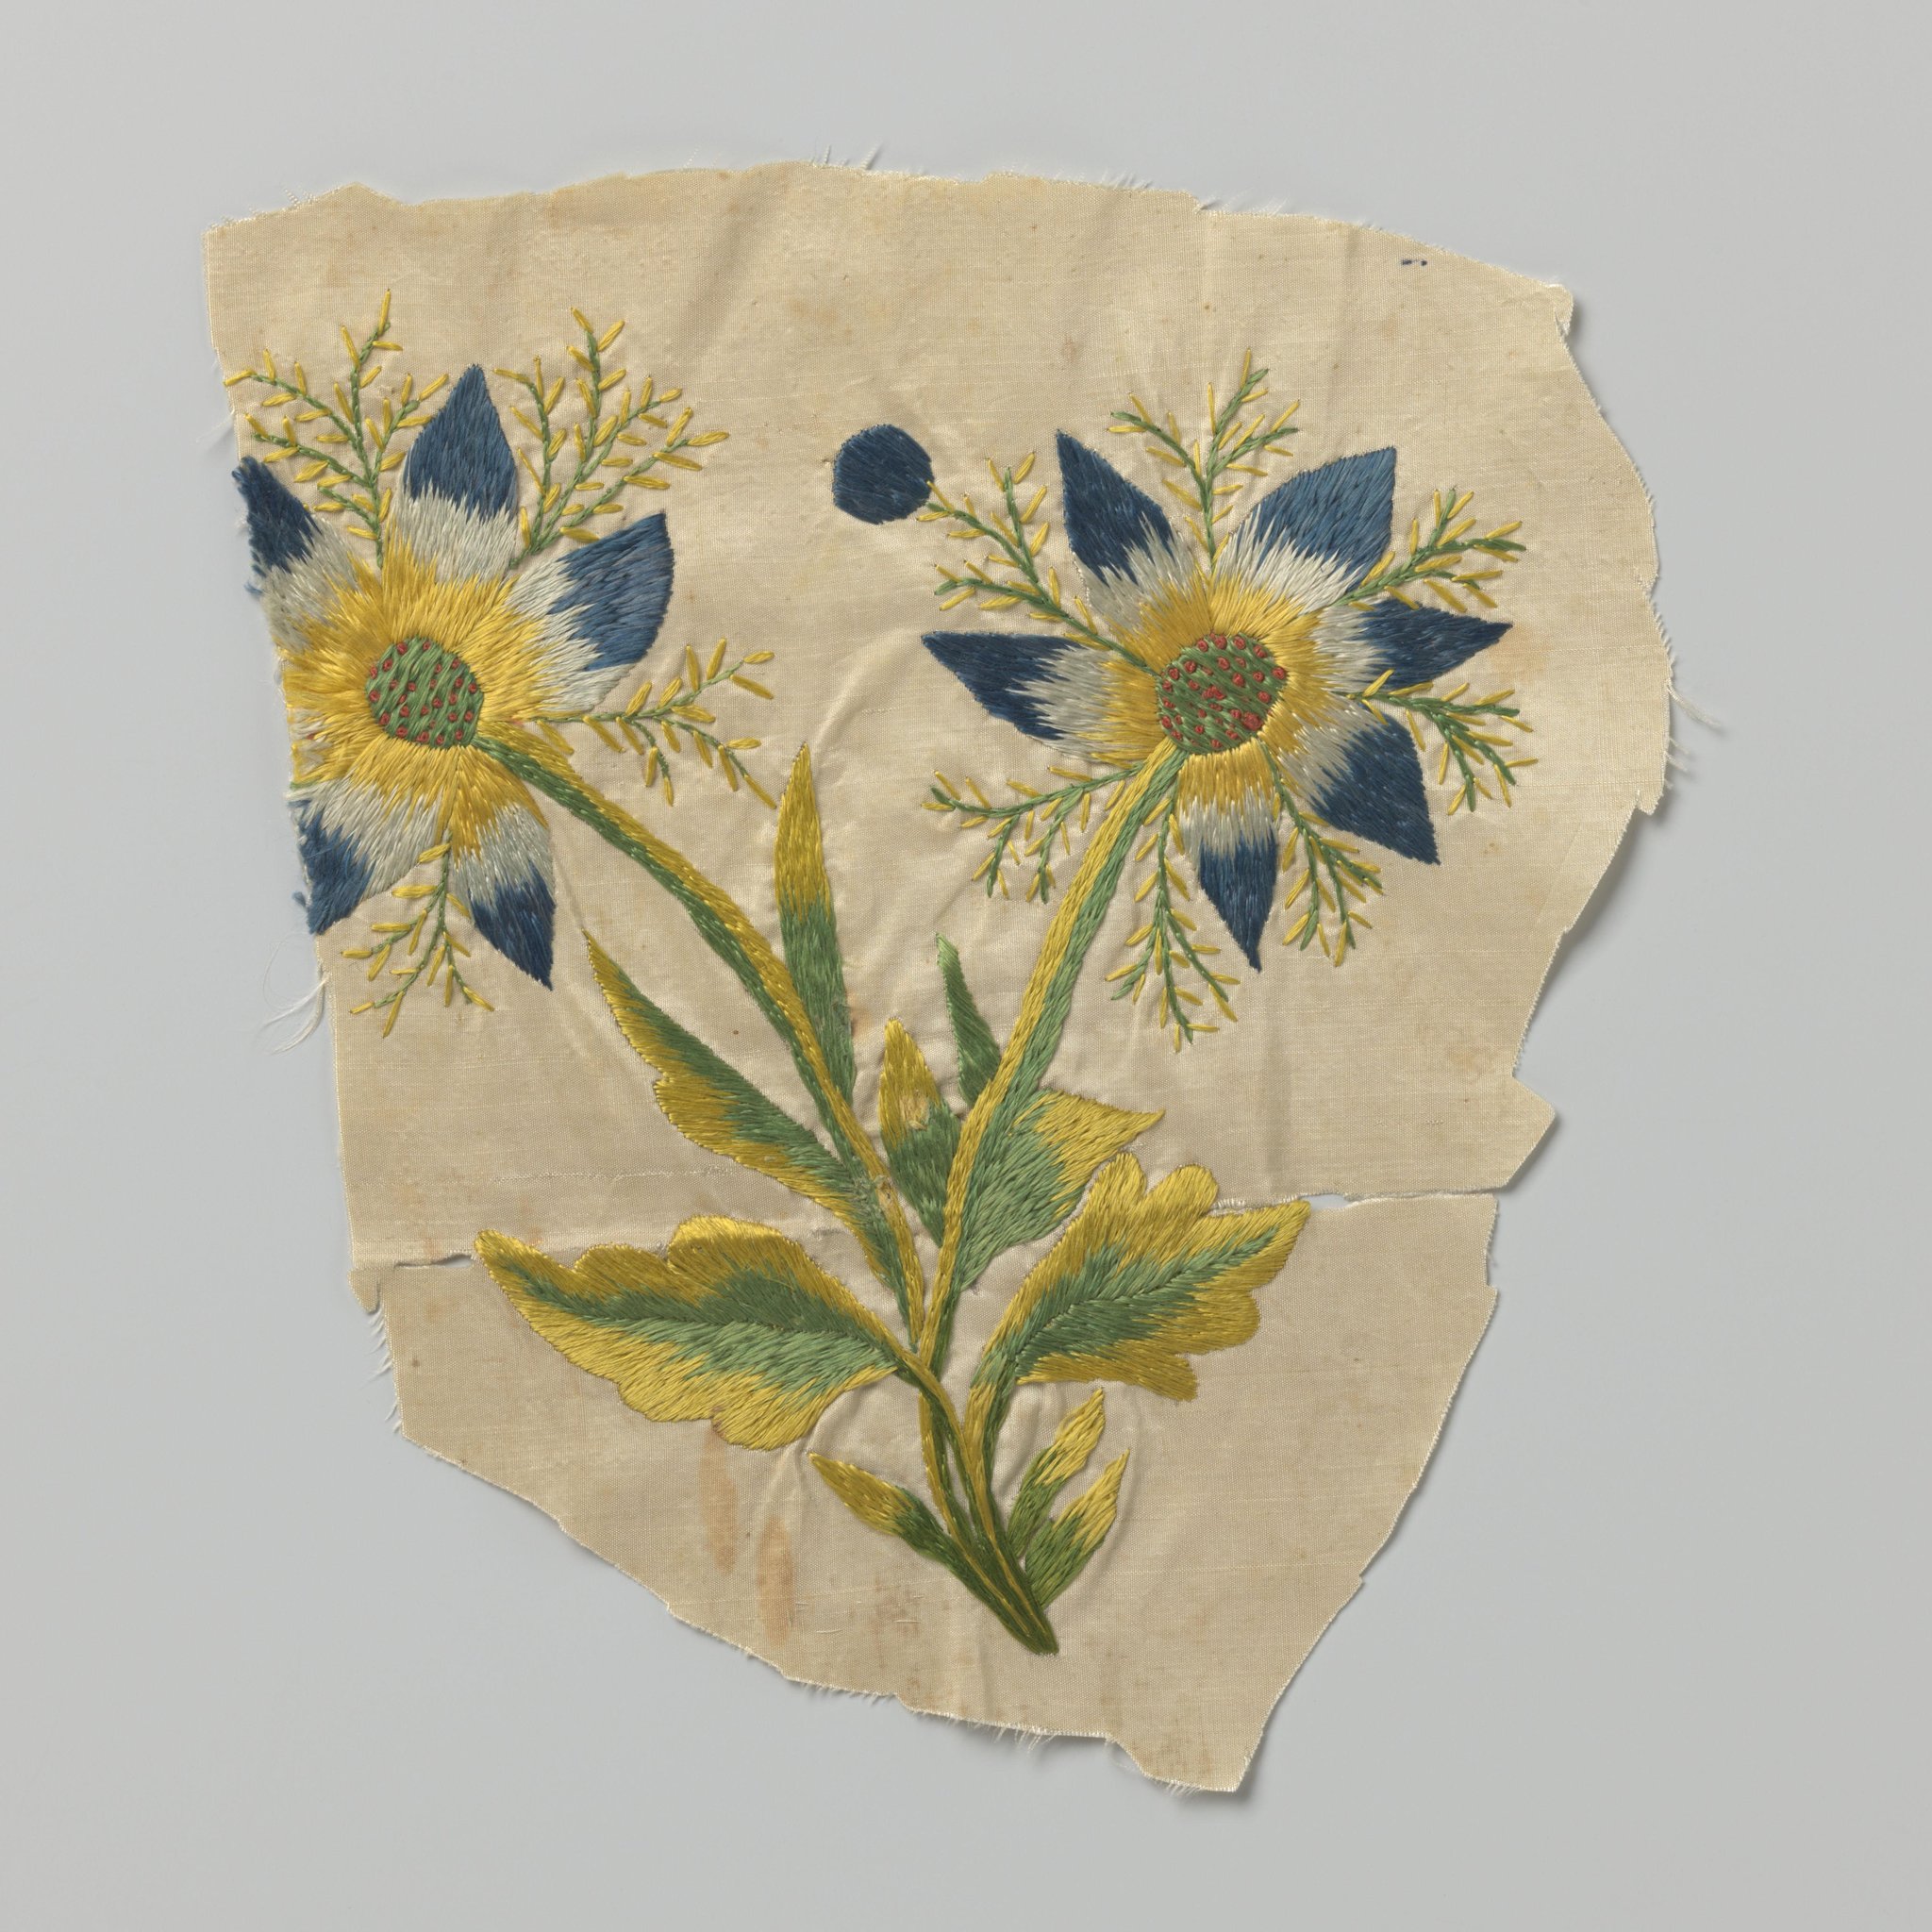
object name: fragment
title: Fragment zijdesatijn met borduurwerk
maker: Anonymous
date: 1700-1799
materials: silk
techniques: embroidered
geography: netherlands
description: Op een grillig geknipt fragment van creme tafzijde is borduursel van floszijde aangebracht. Het patroon heeft twee grote stervormige bloemen die met dikke stelen uit een bladtak komen.